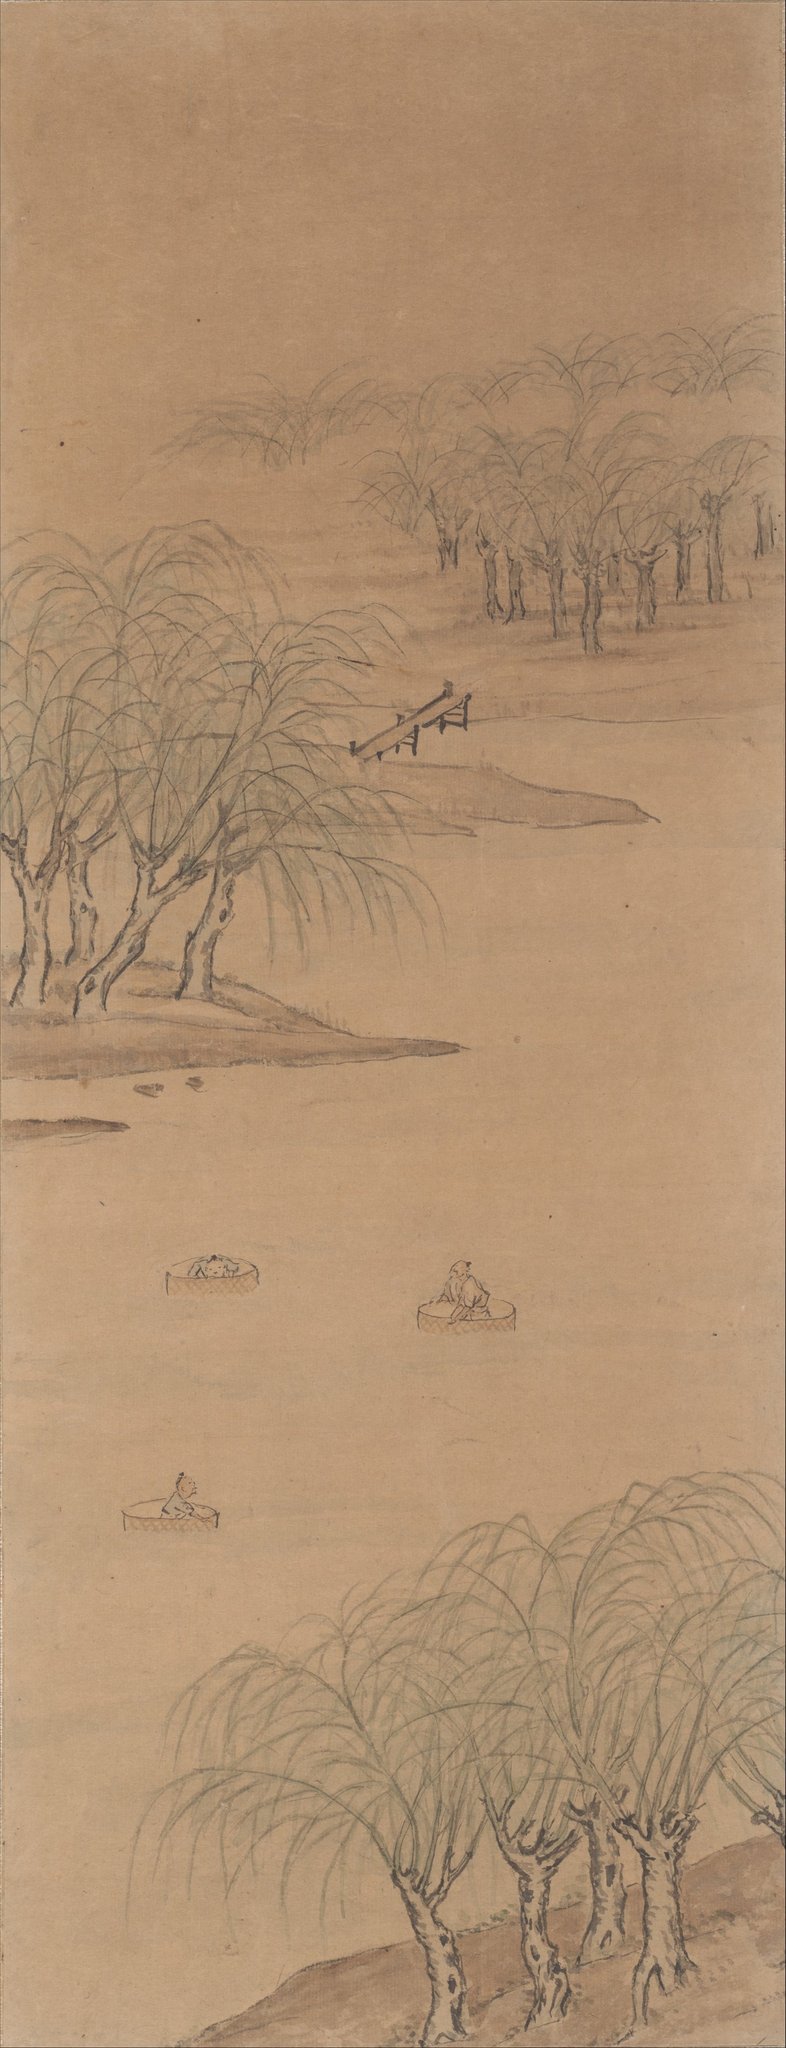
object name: album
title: Painting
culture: chinese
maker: bi chang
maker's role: artist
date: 1701-1900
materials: ink, paper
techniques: painting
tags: rivers,landscapes,boats